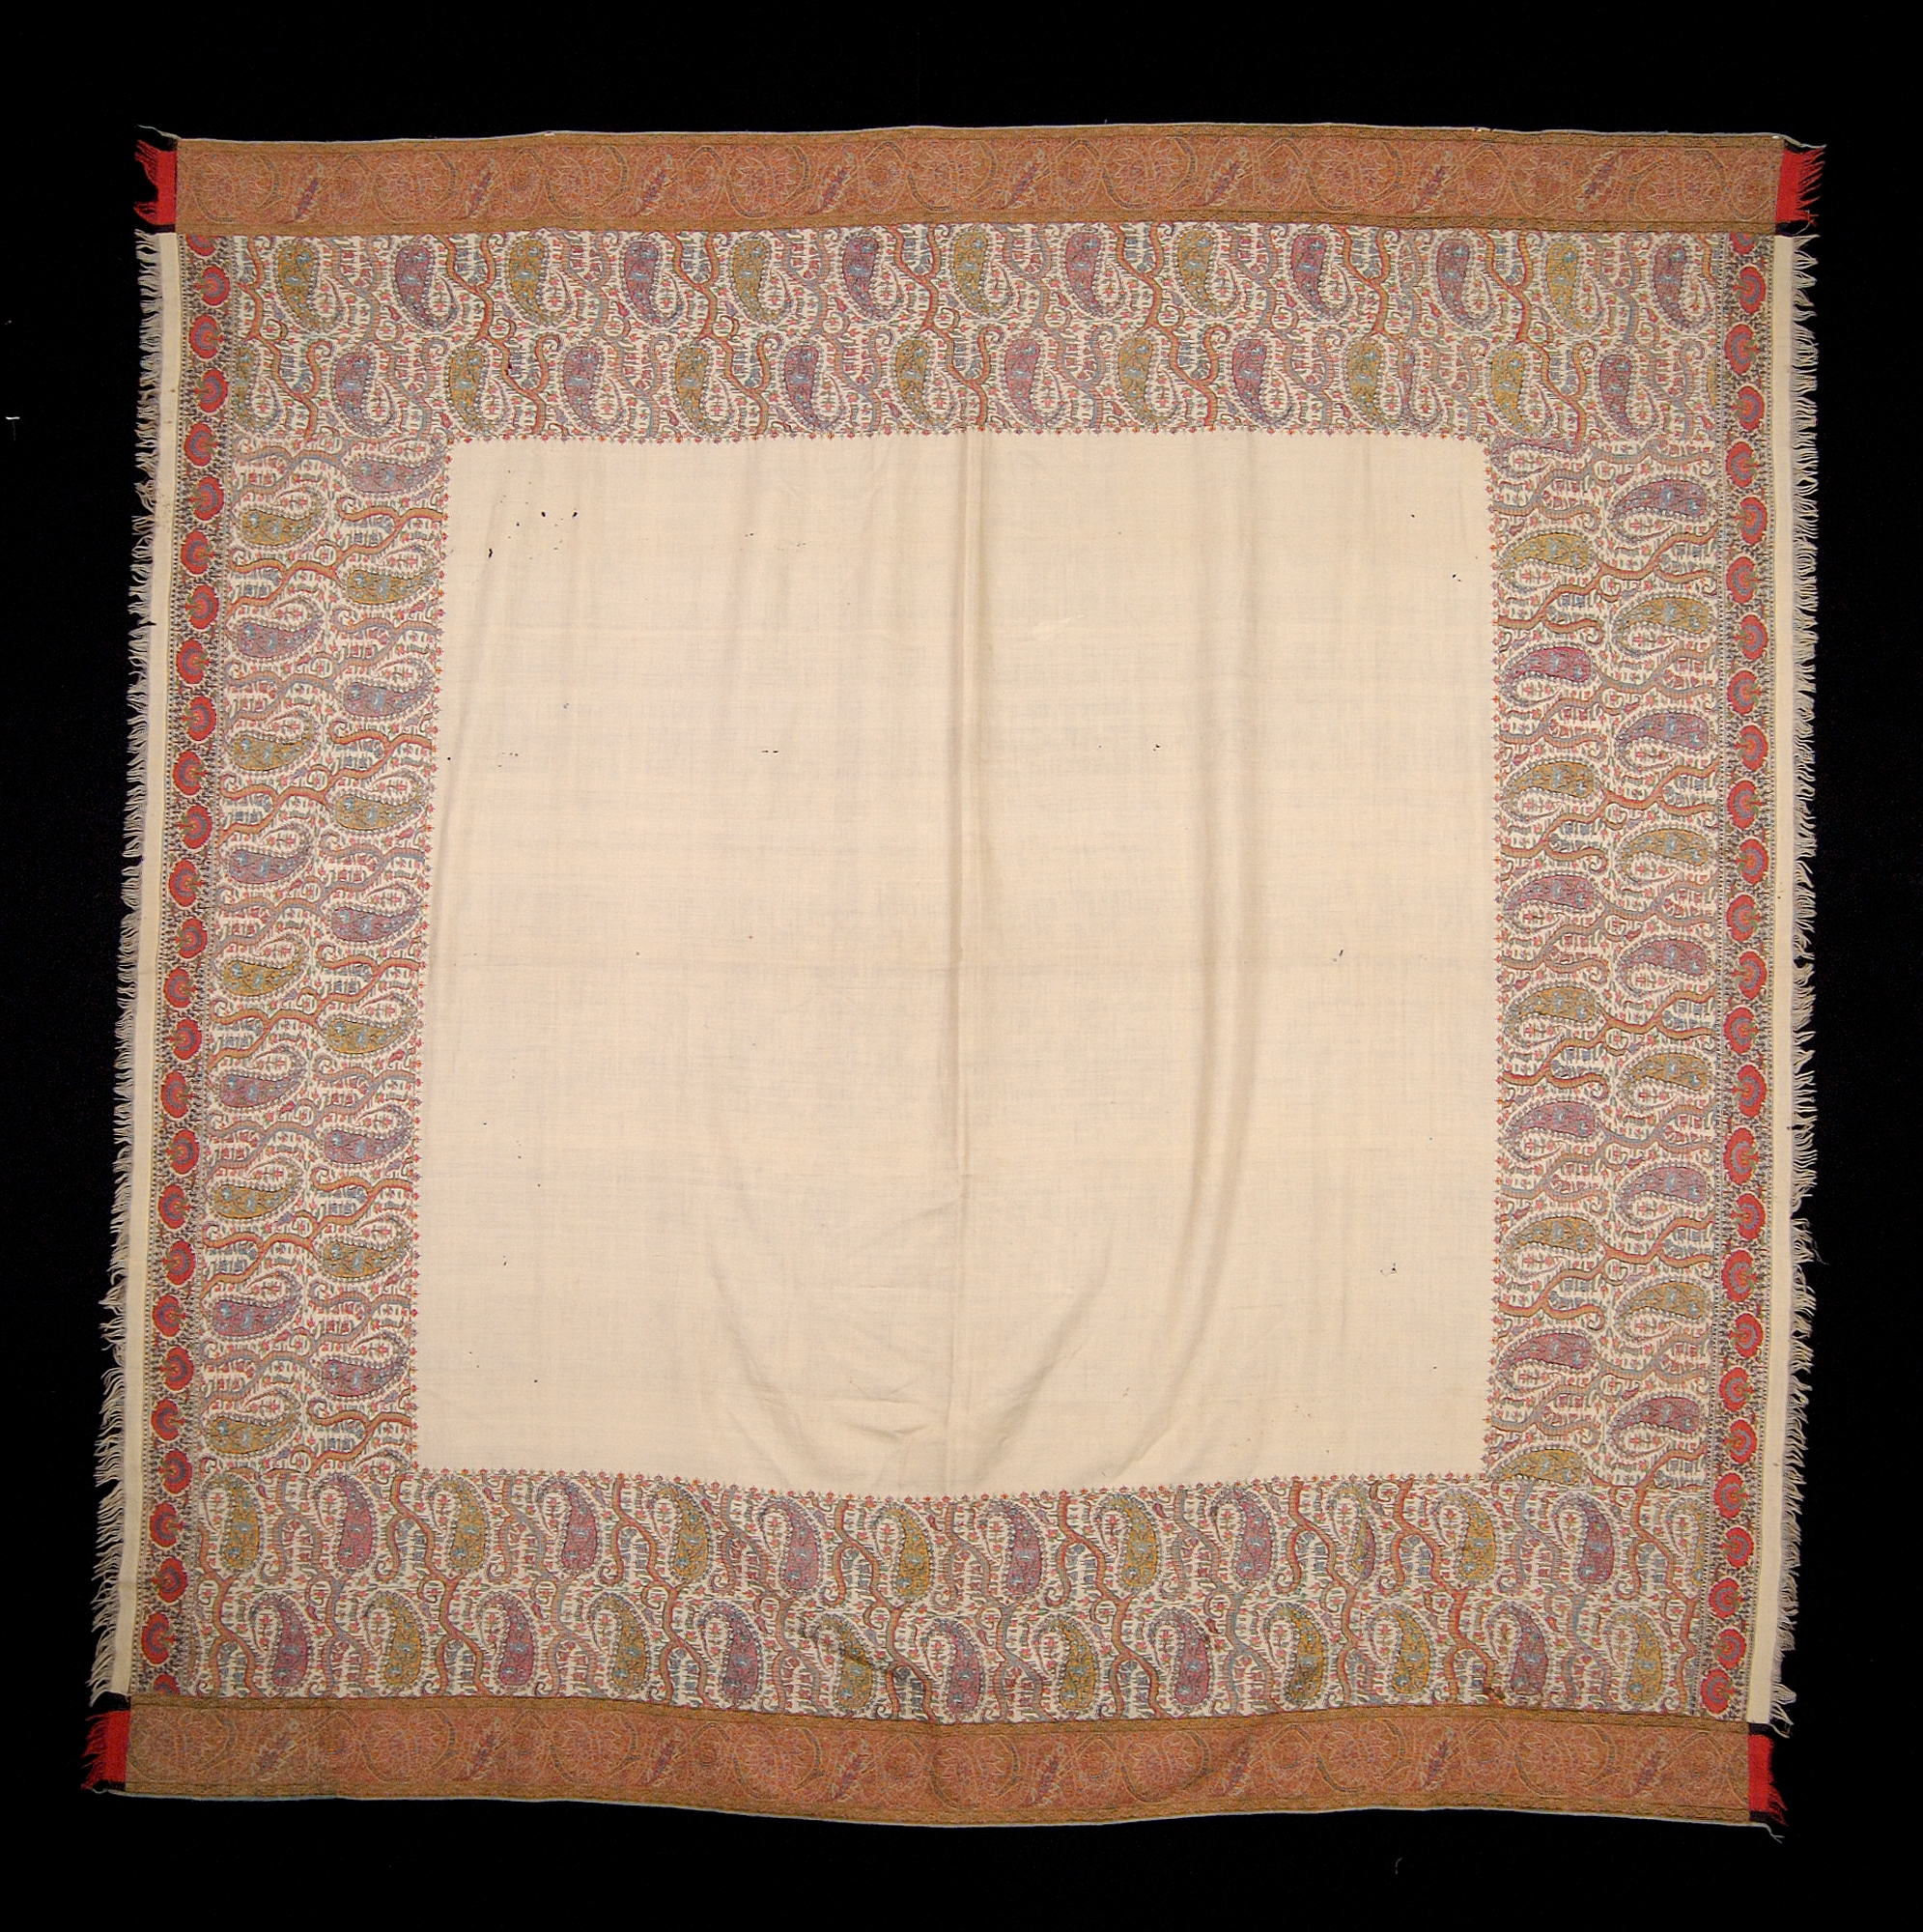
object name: shawl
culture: scottish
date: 1851-1875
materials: wool